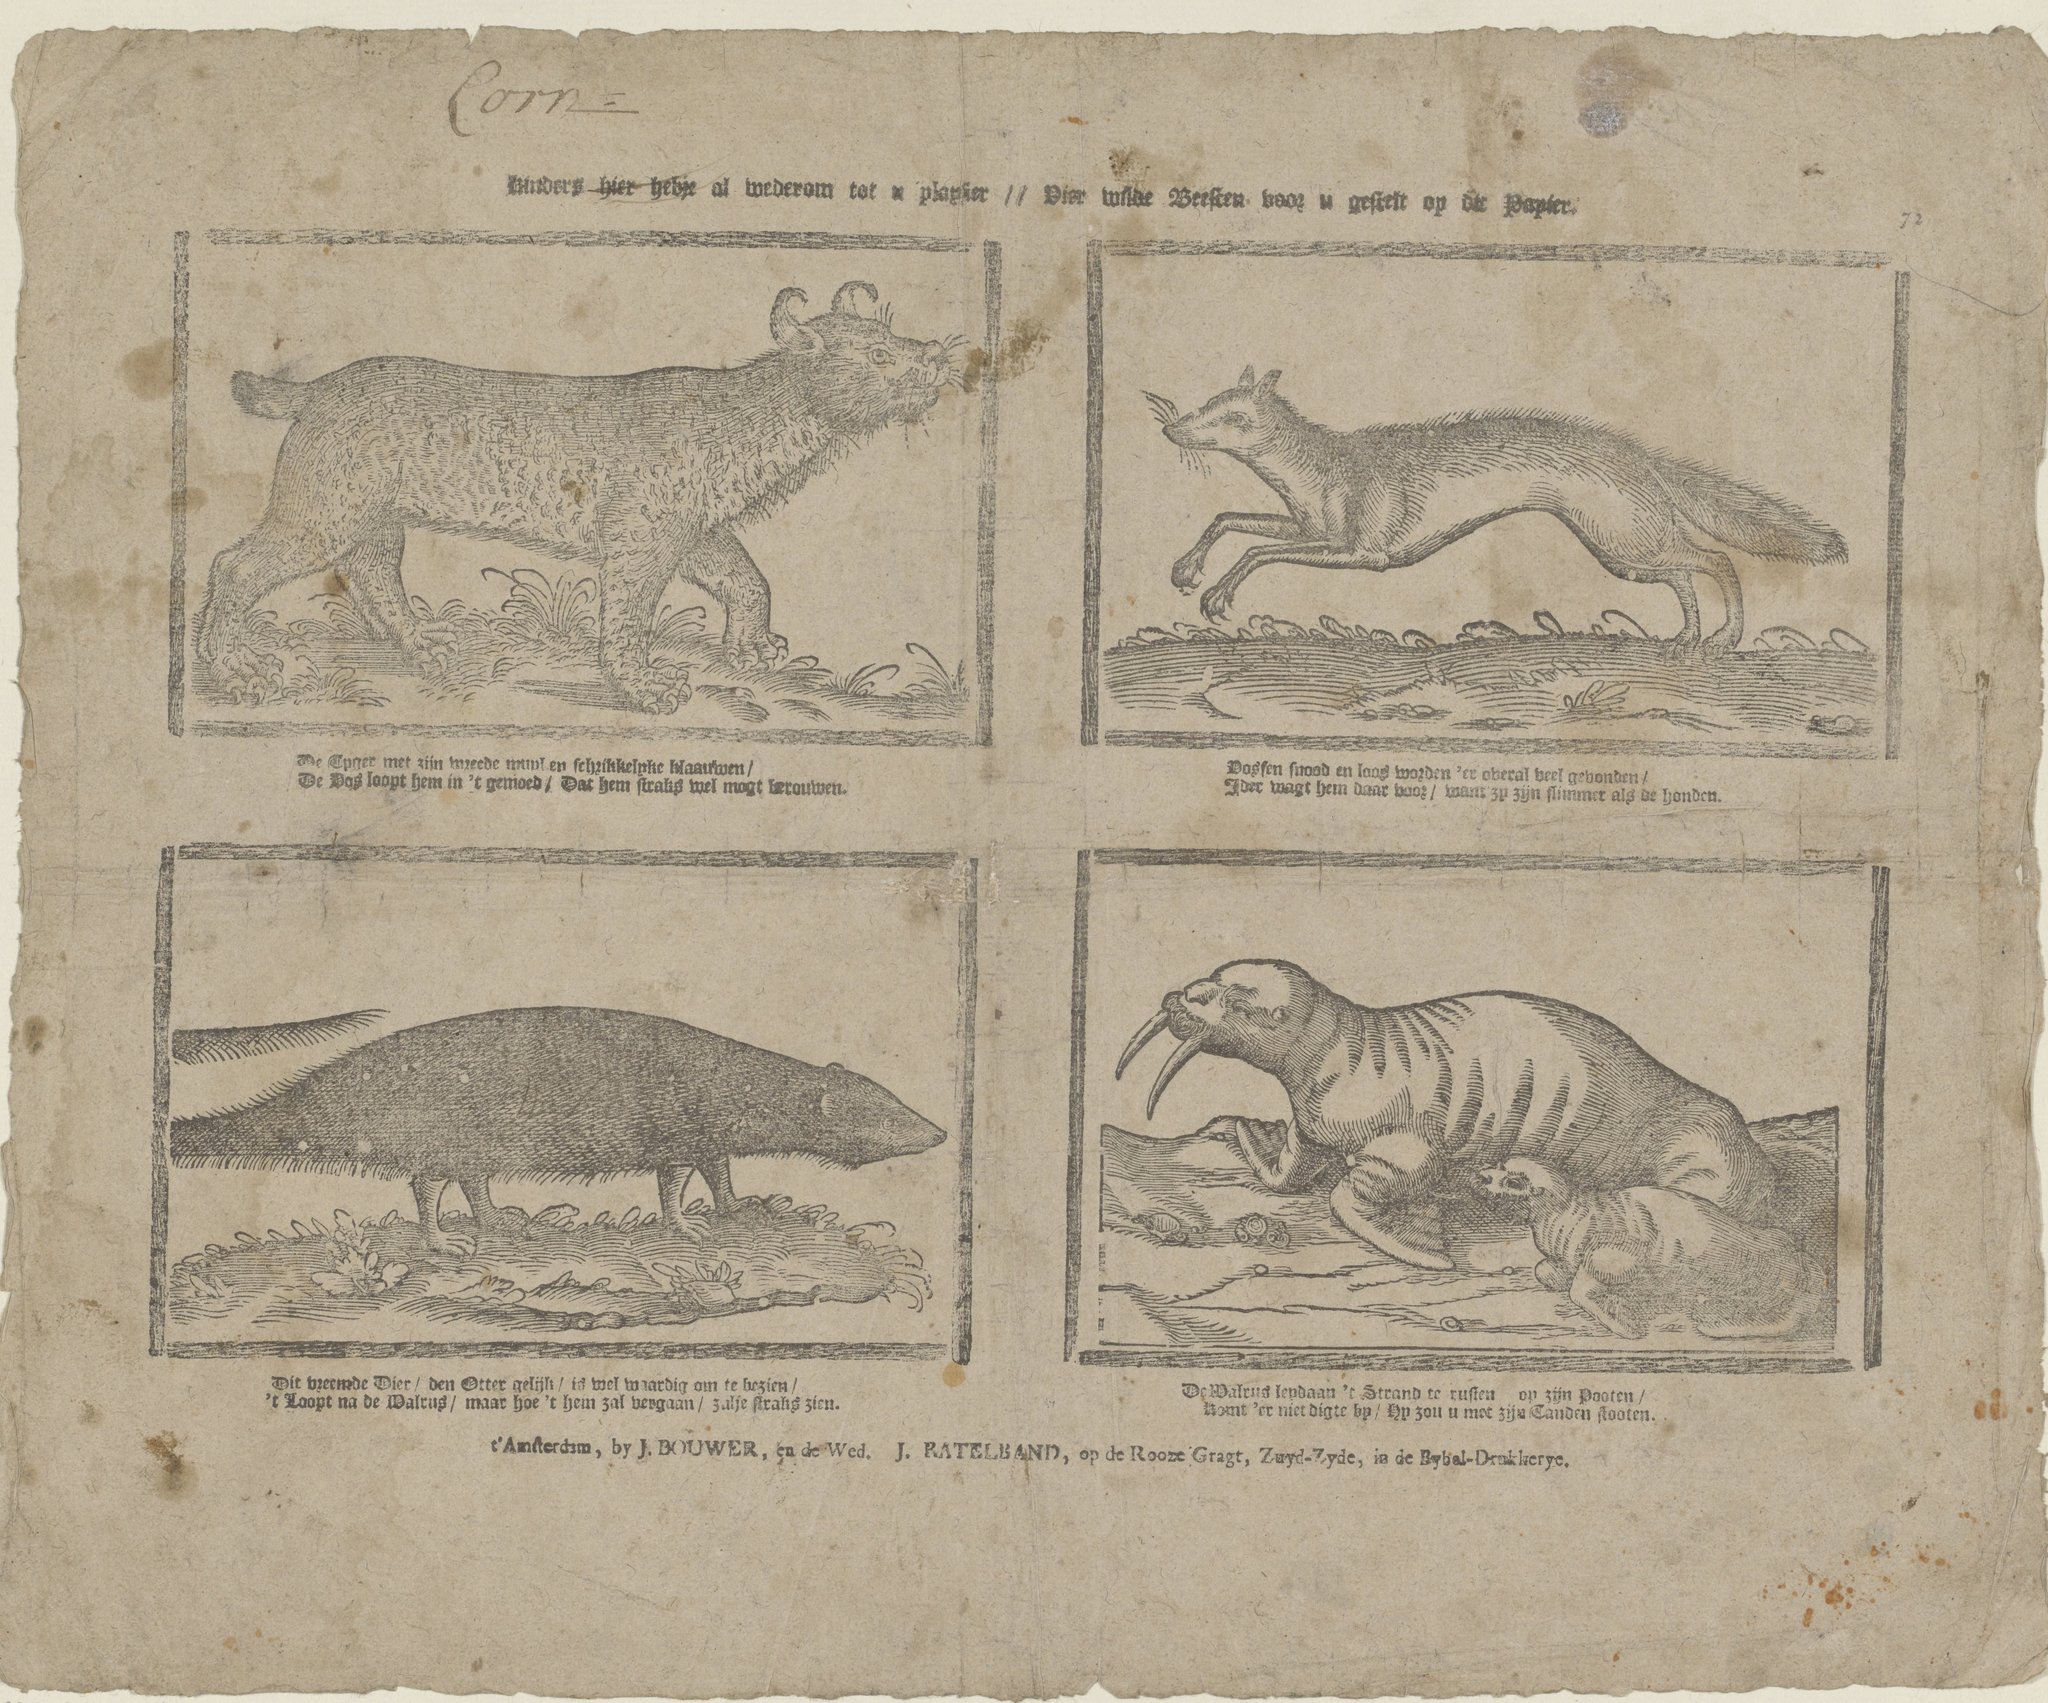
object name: popular print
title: Kinders hier hebje wederom tot u playsier // Vier wilde beesten voor u gestelt op dit papier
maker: Anonymous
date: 1551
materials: paper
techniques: letterpress printing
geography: amsterdam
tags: beasts of prey, predatory animals: tiger, animals, beasts of prey, predatory animals: otter, swimming mammals: walrus, beasts of prey, predatory animals: fox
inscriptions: collector's mark: Lugt 2760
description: Voor het drukken van deze prent is gebruik gemaakt van bestaande houtblokken die in de zestiende eeuw gebruikt werden voor de befaamde natuurhistorische boeken van de Zwitser Conrad Gessner. Minstens een deel van de houtblokken voor de illustraties van Gessners werk bevond zich in de achttiende en vroege negentiende eeuw in Nederland. Daar werden ze benut voor het drukken van cents- of volksprenten. De nogal willekeurige kleuring op de prenten is typerend voor dit soort goedkope grafiek. Opvallend is dat de dieren in de tekstjes die onder de afbeeldingen werden toegevoegd vaak anders zijn geduid dan bij Gessner. Al deze dieren komen voor in verschillende publicaties van Gessner, alsmede herdrukken daarvan, zoals het eerste deel van Historiae animalium (eerste uitgave 1551), Icones animalium quadrupedum (eerste uitgave 1553) en Thierbuch (eerste uitgave 1563).